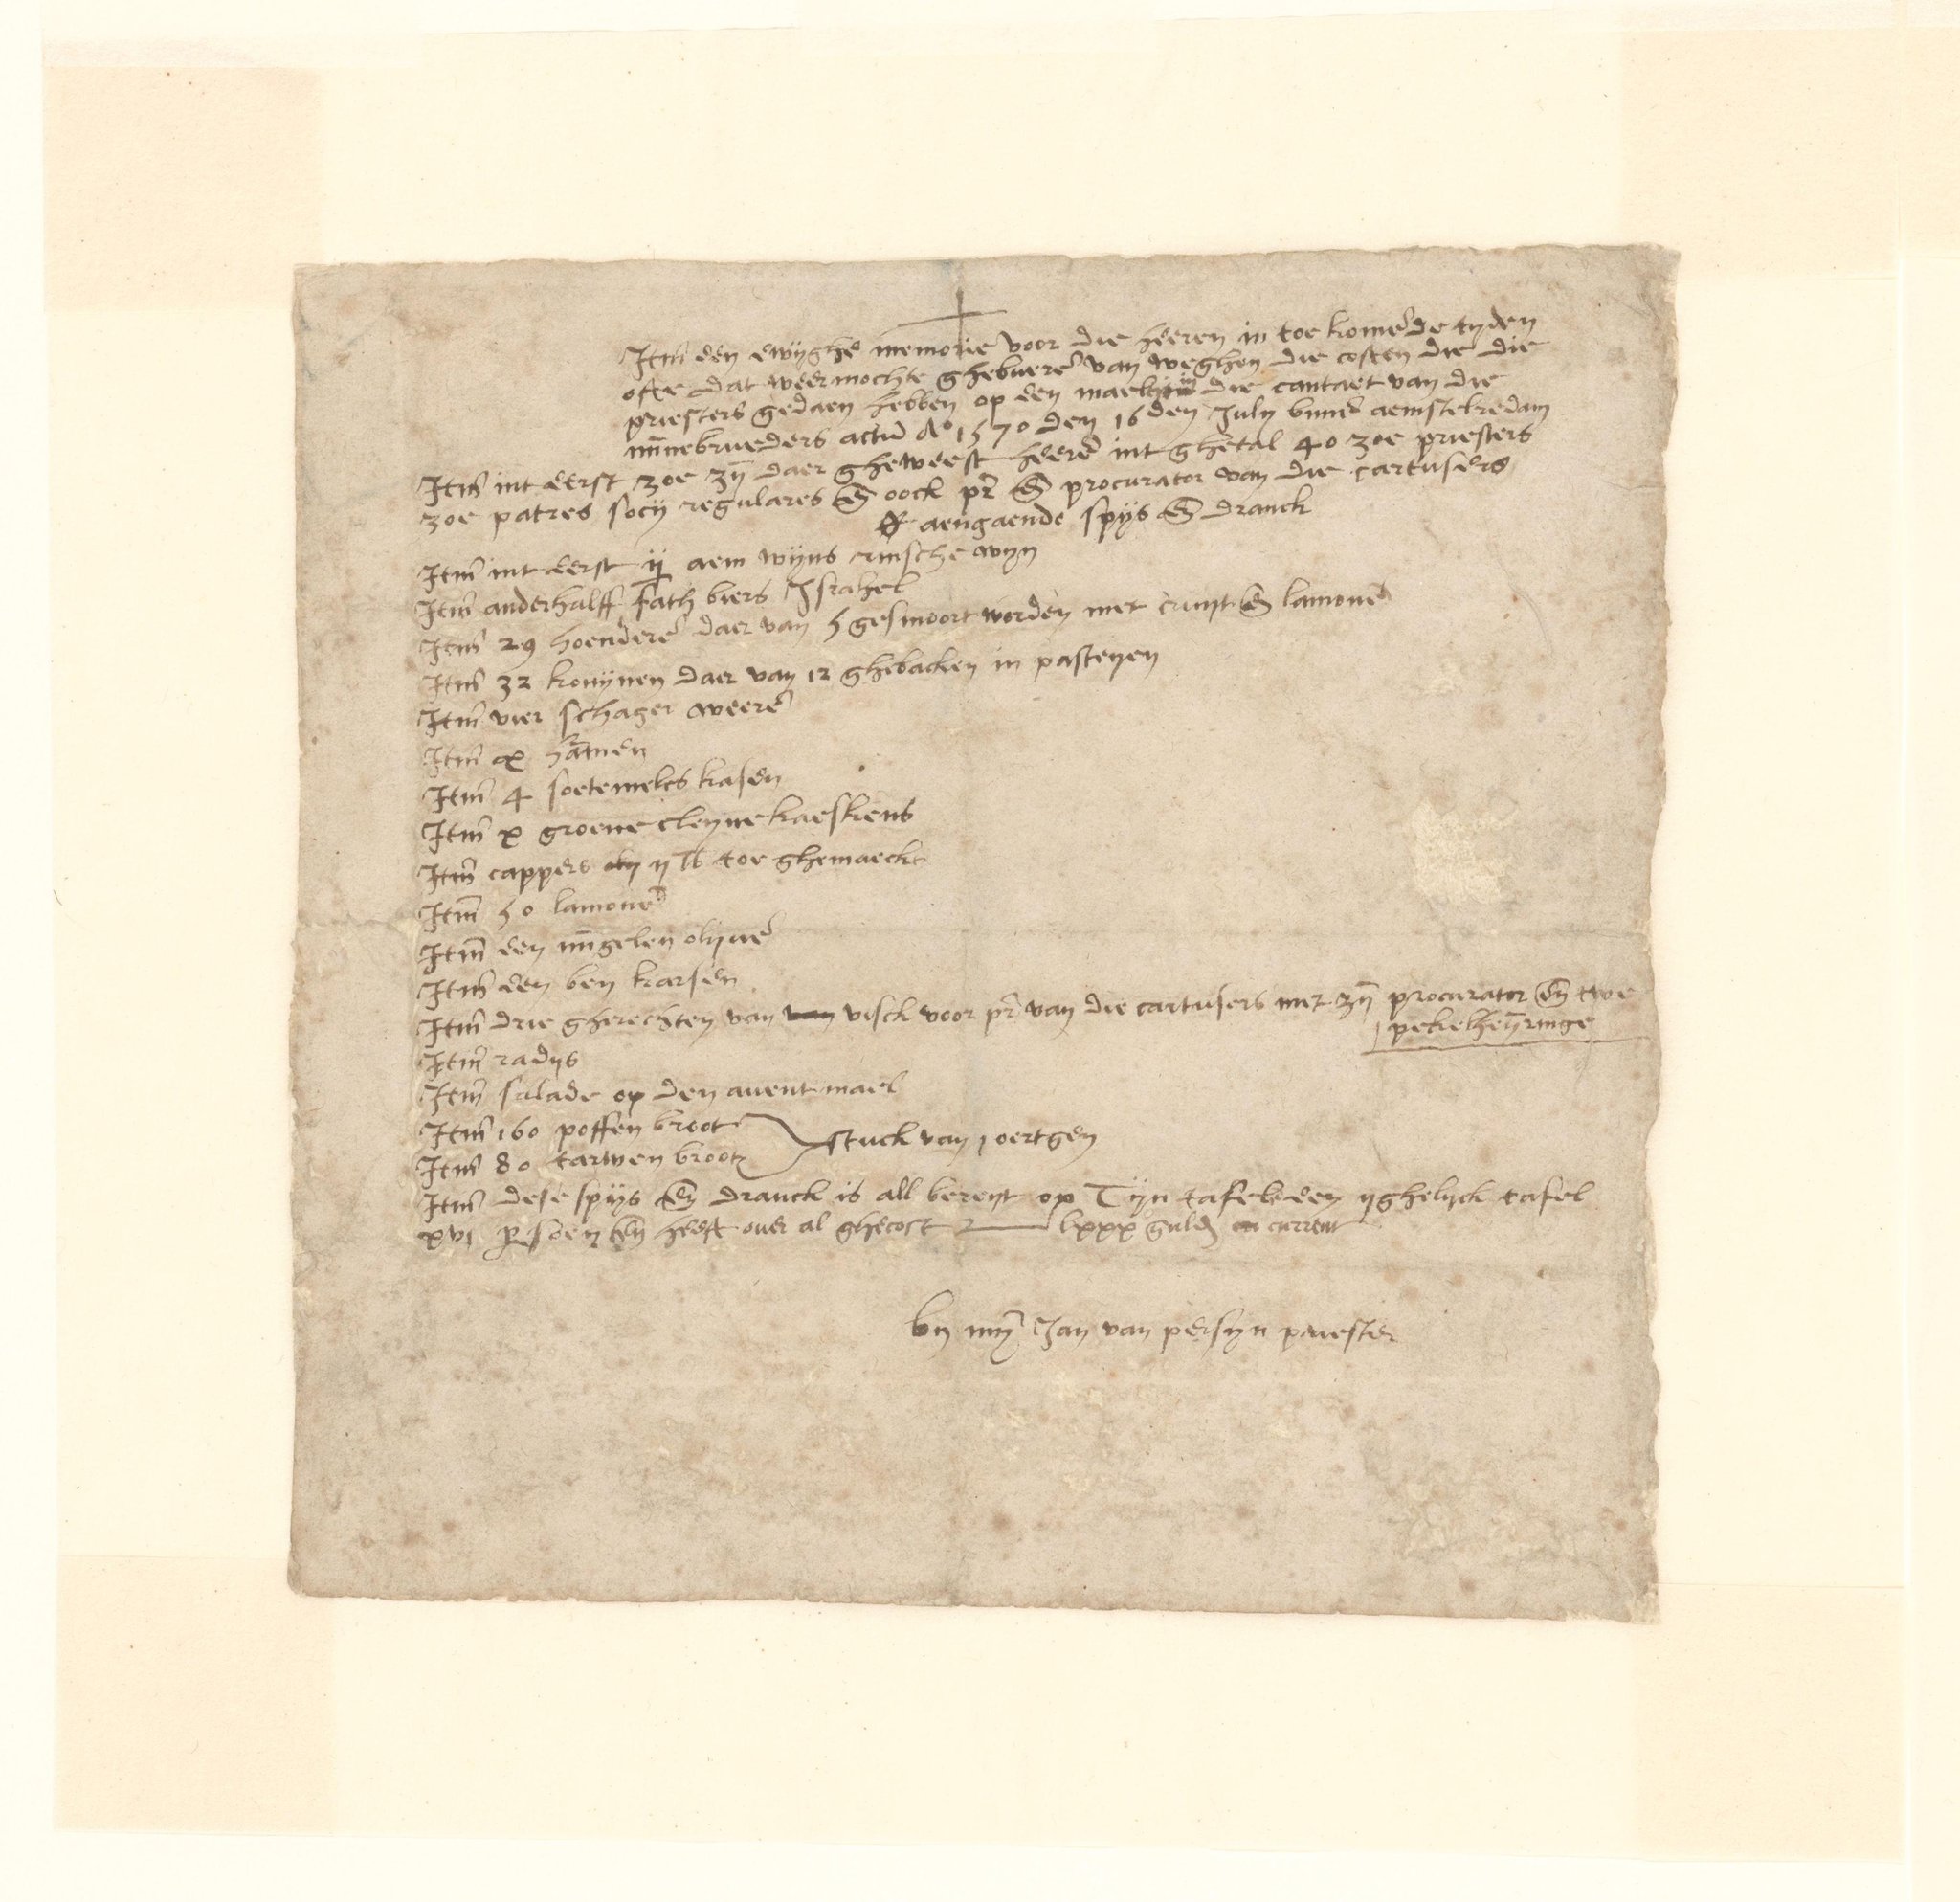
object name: text sheet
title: Inventarislijst voor de kosten en hoeveelheden van eten en drank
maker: Anonymous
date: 1570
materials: ink, paper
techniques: pen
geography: amsterdam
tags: handwriting, written text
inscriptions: number: ‘17’, inscription: ‘Een euwige memorie (...) van persyn priester’